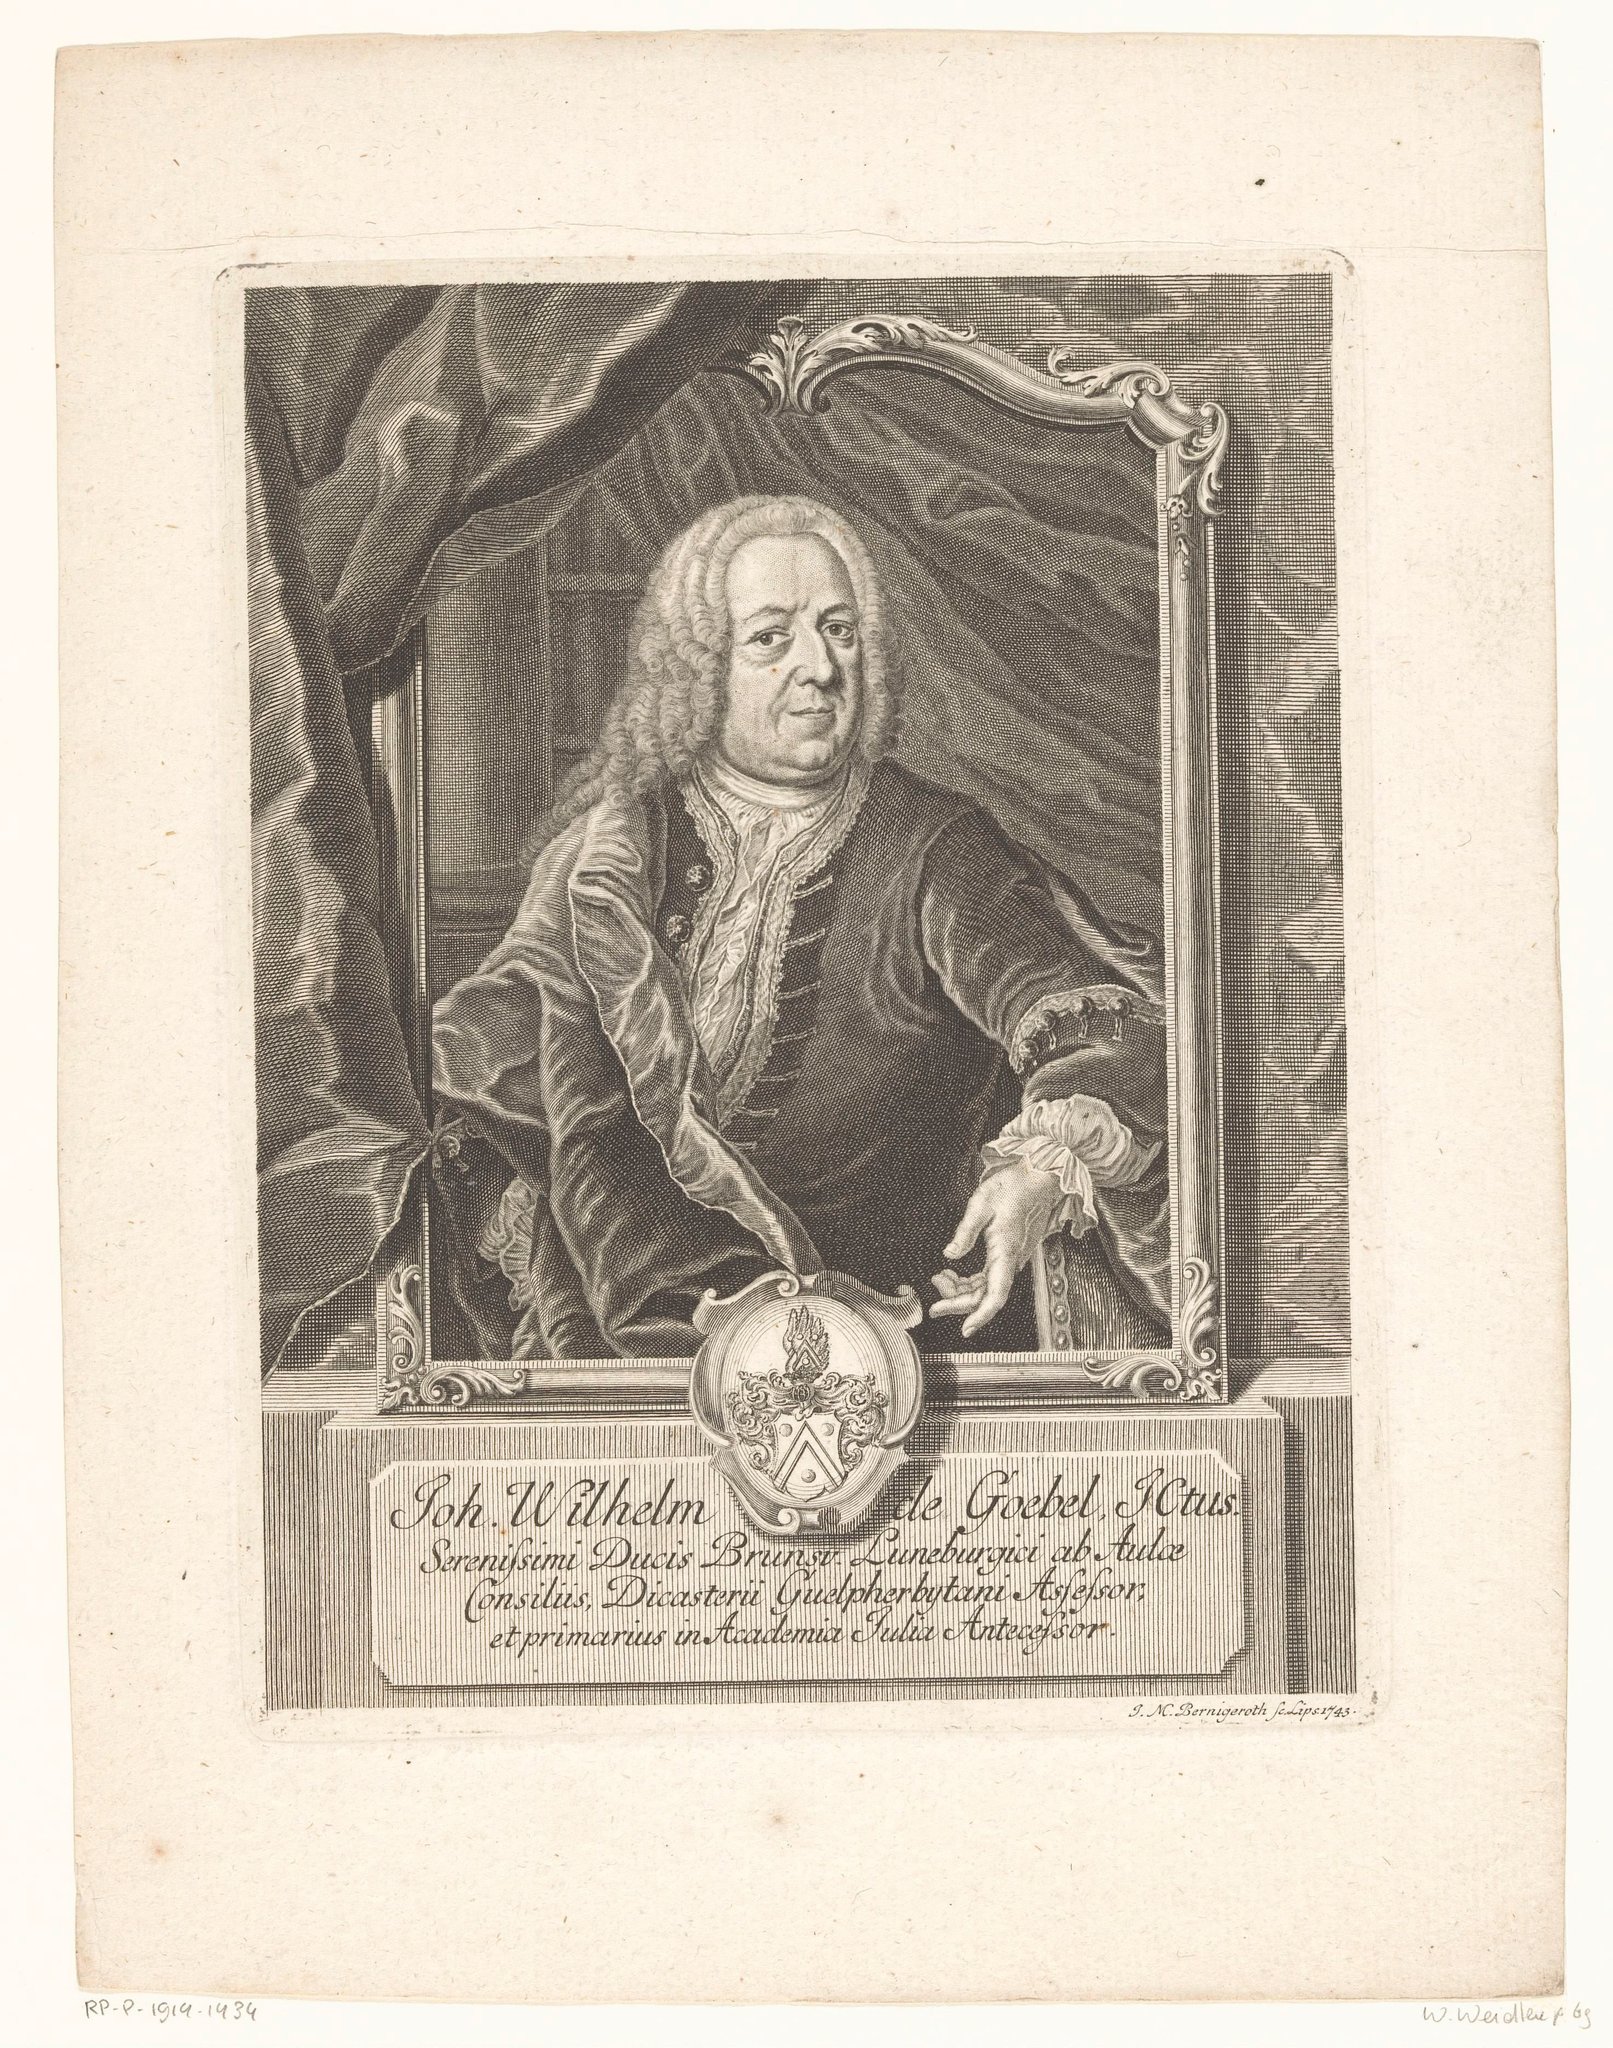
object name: print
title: Portret van Johann Wilhelm von Göbel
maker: johann martin bernigeroth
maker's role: print maker, publisher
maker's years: 1713-1767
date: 1743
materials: paper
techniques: engraving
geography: leipzig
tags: historical persons, armorial bearing, heraldry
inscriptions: collector's mark: Lugt 2228